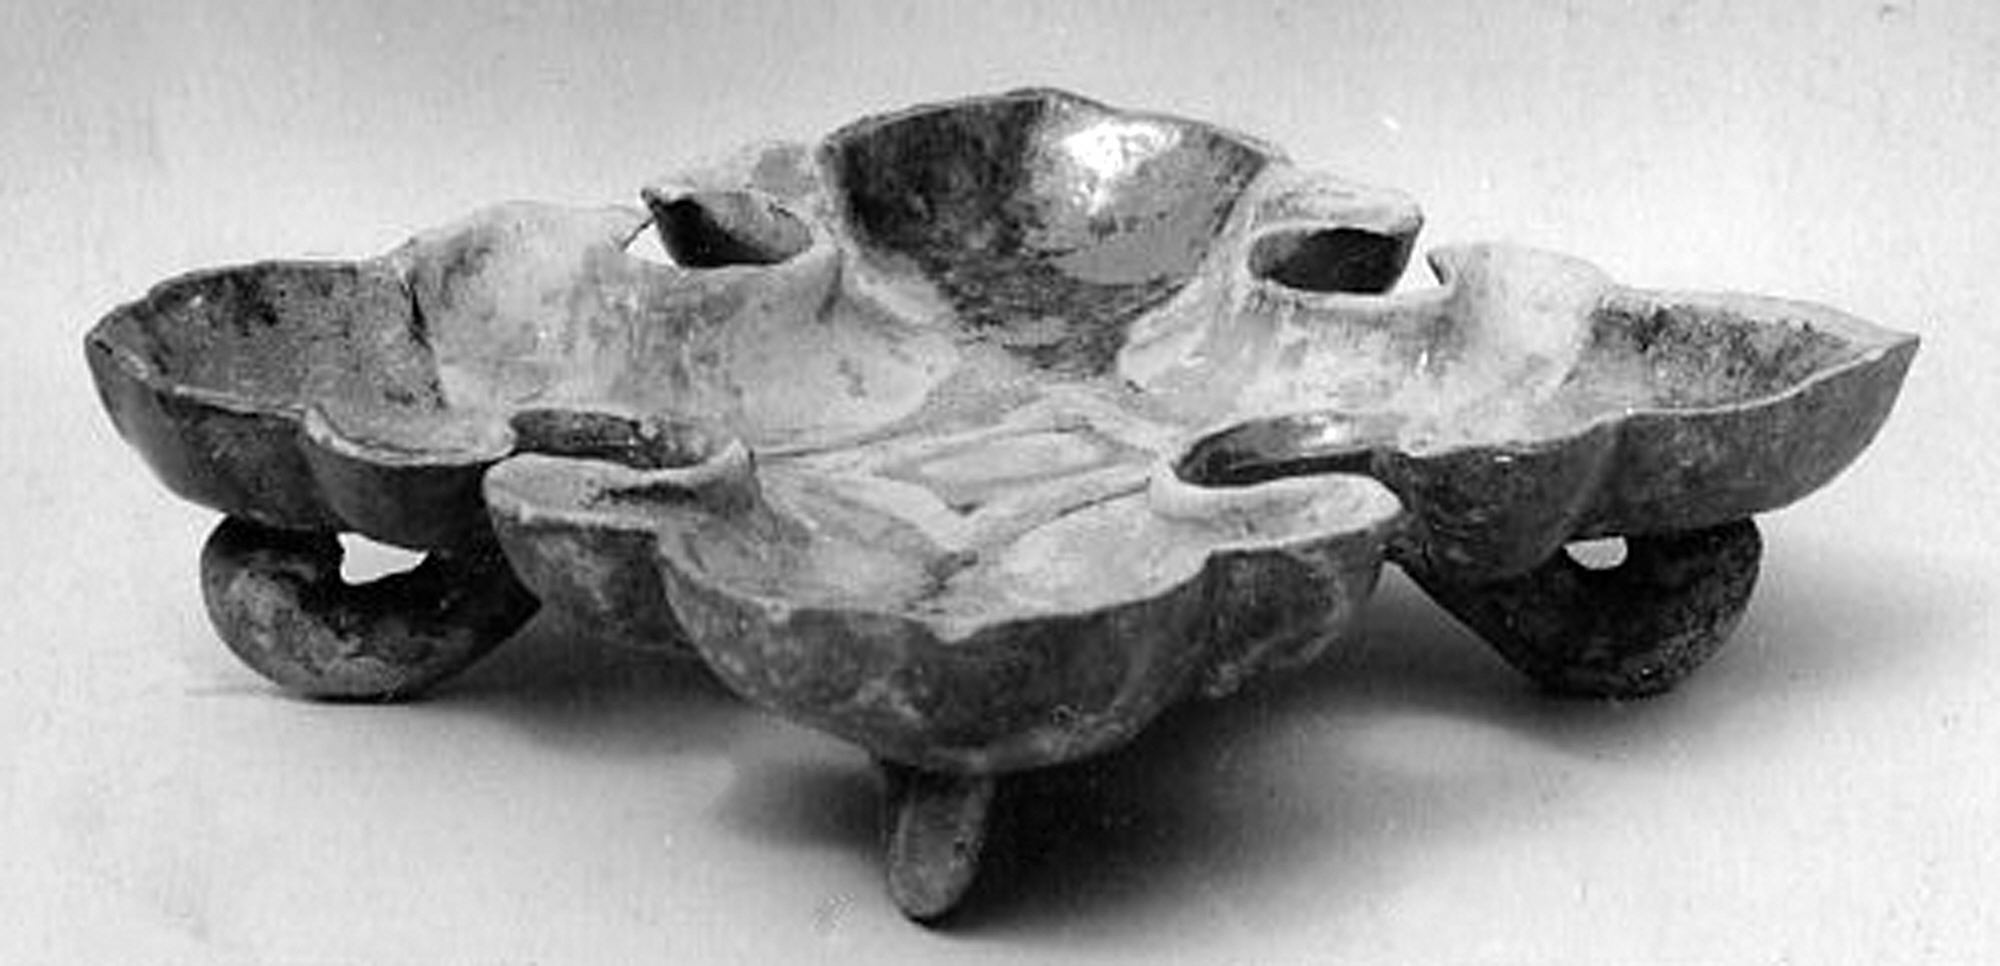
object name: dish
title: Dish in the shape of flower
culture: chinese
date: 618-907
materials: earthenware, glaze